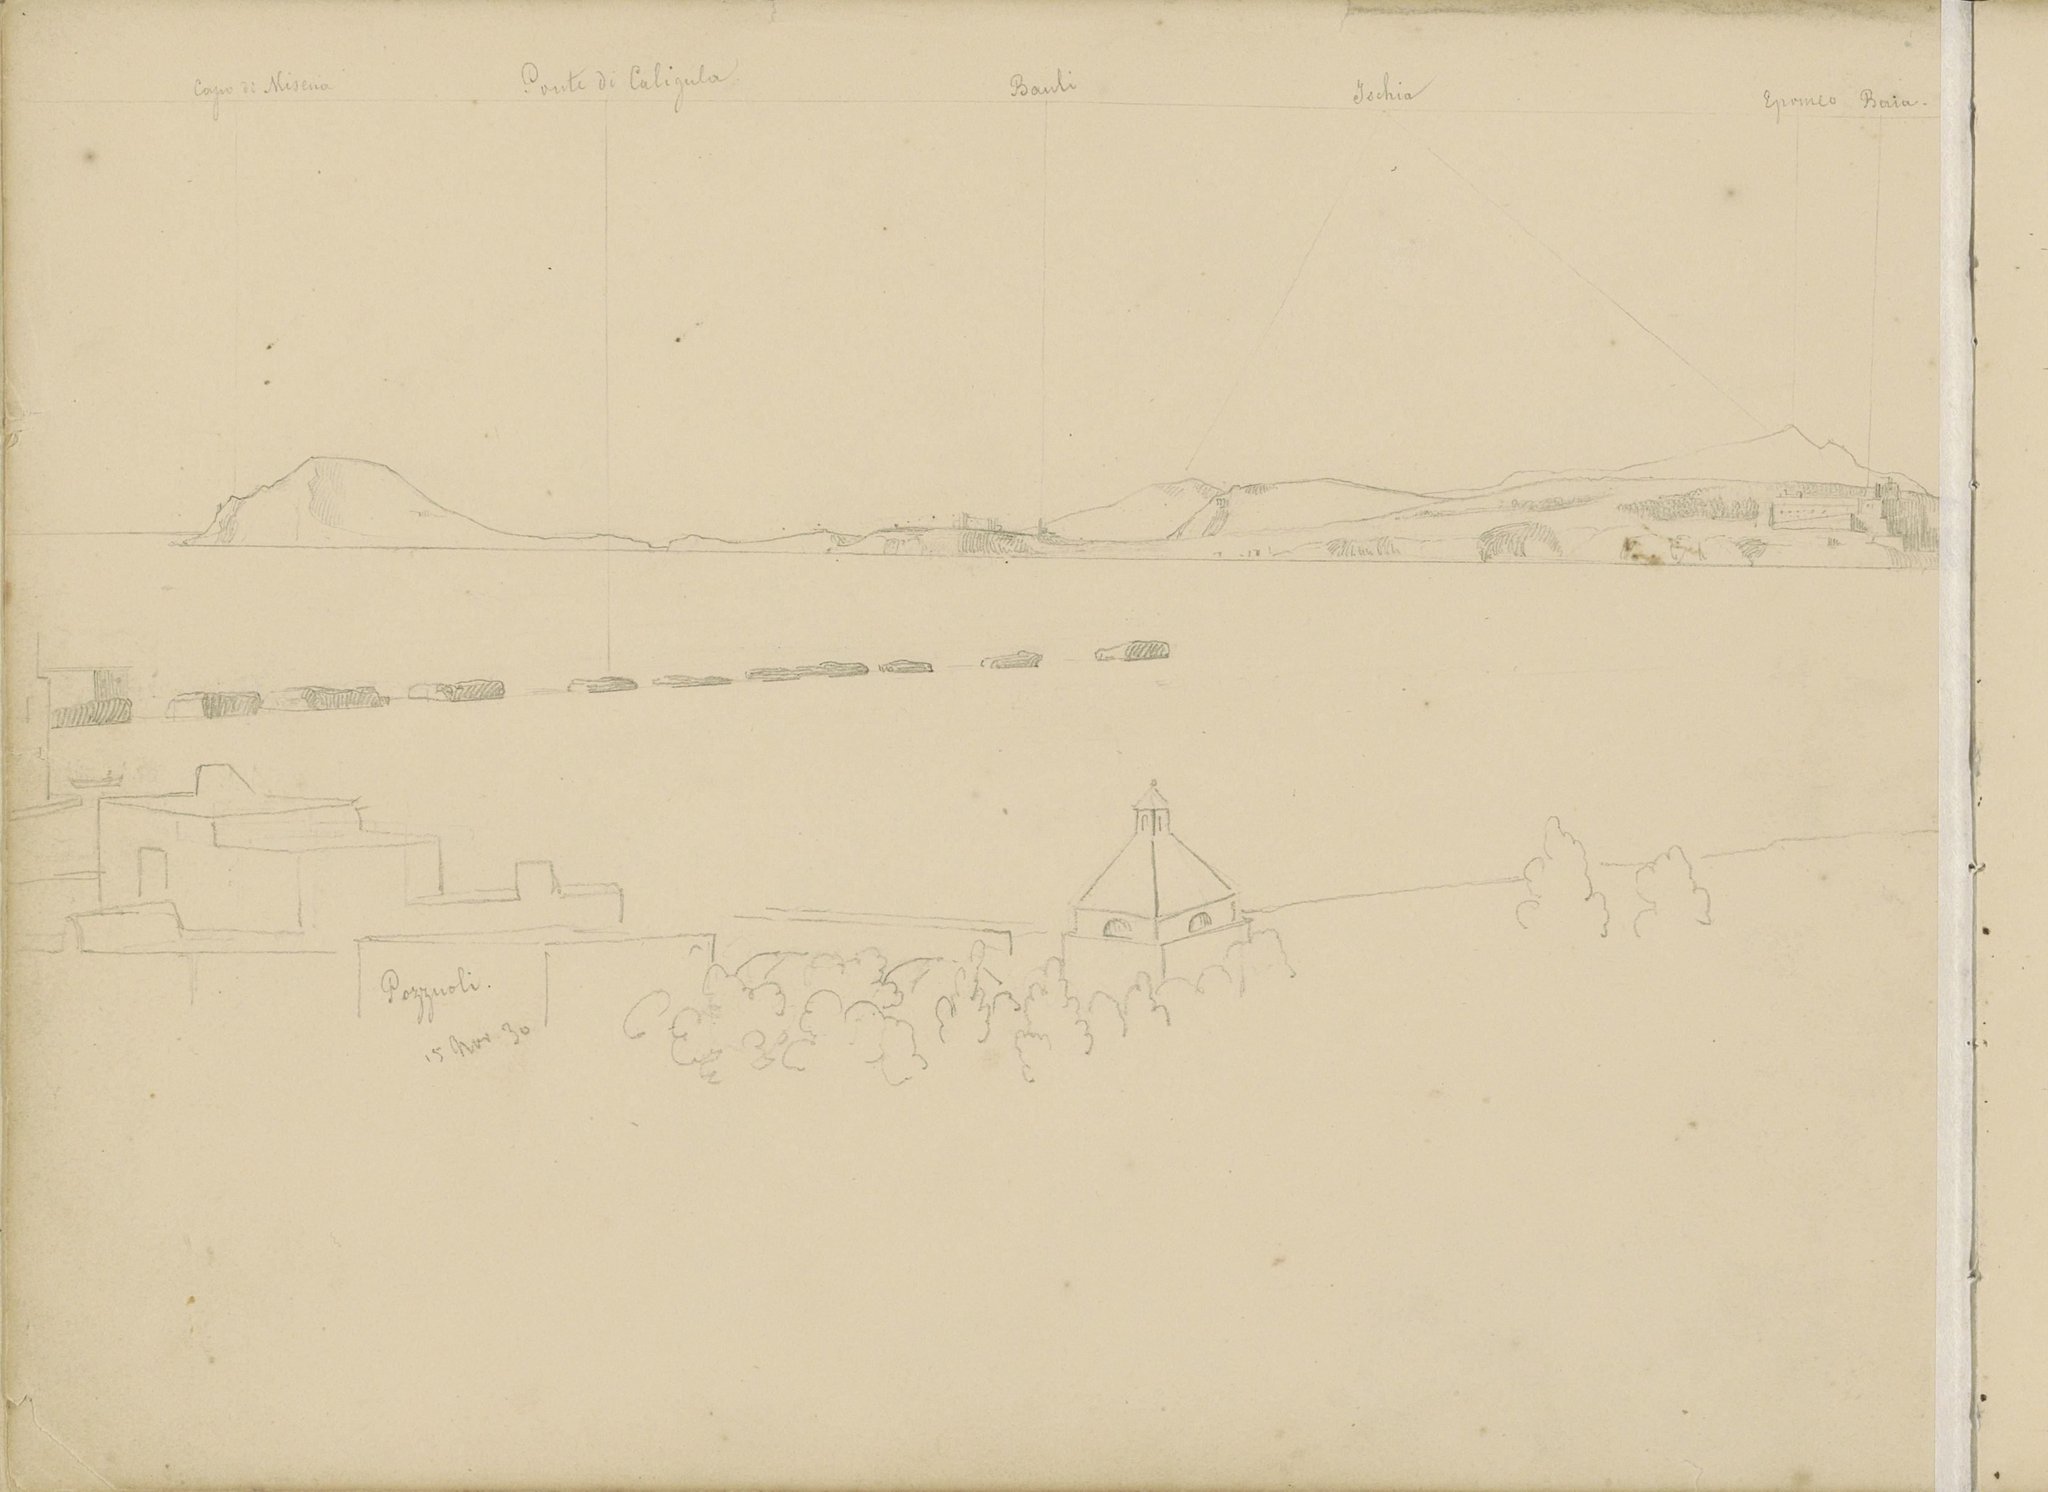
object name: sketchbook leaf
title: Gezicht vanaf Pozzuoli op de baai van Napels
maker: jacobus everhardus josephus van den berg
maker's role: draughtsman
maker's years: 1802-1861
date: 1811-1830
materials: paper, pencil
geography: pozzuoli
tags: gulf, bay, pozzuoli, ischia, isola d'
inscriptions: date and inscription: ‘capo di Miseno/ Porte di Caligula/ Bacoli/ Ischia/ epomeo Baia/ Pozzuoli/ 15 Nov 30’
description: Blad 9 verso uit een schetsboek met 26 bladen.